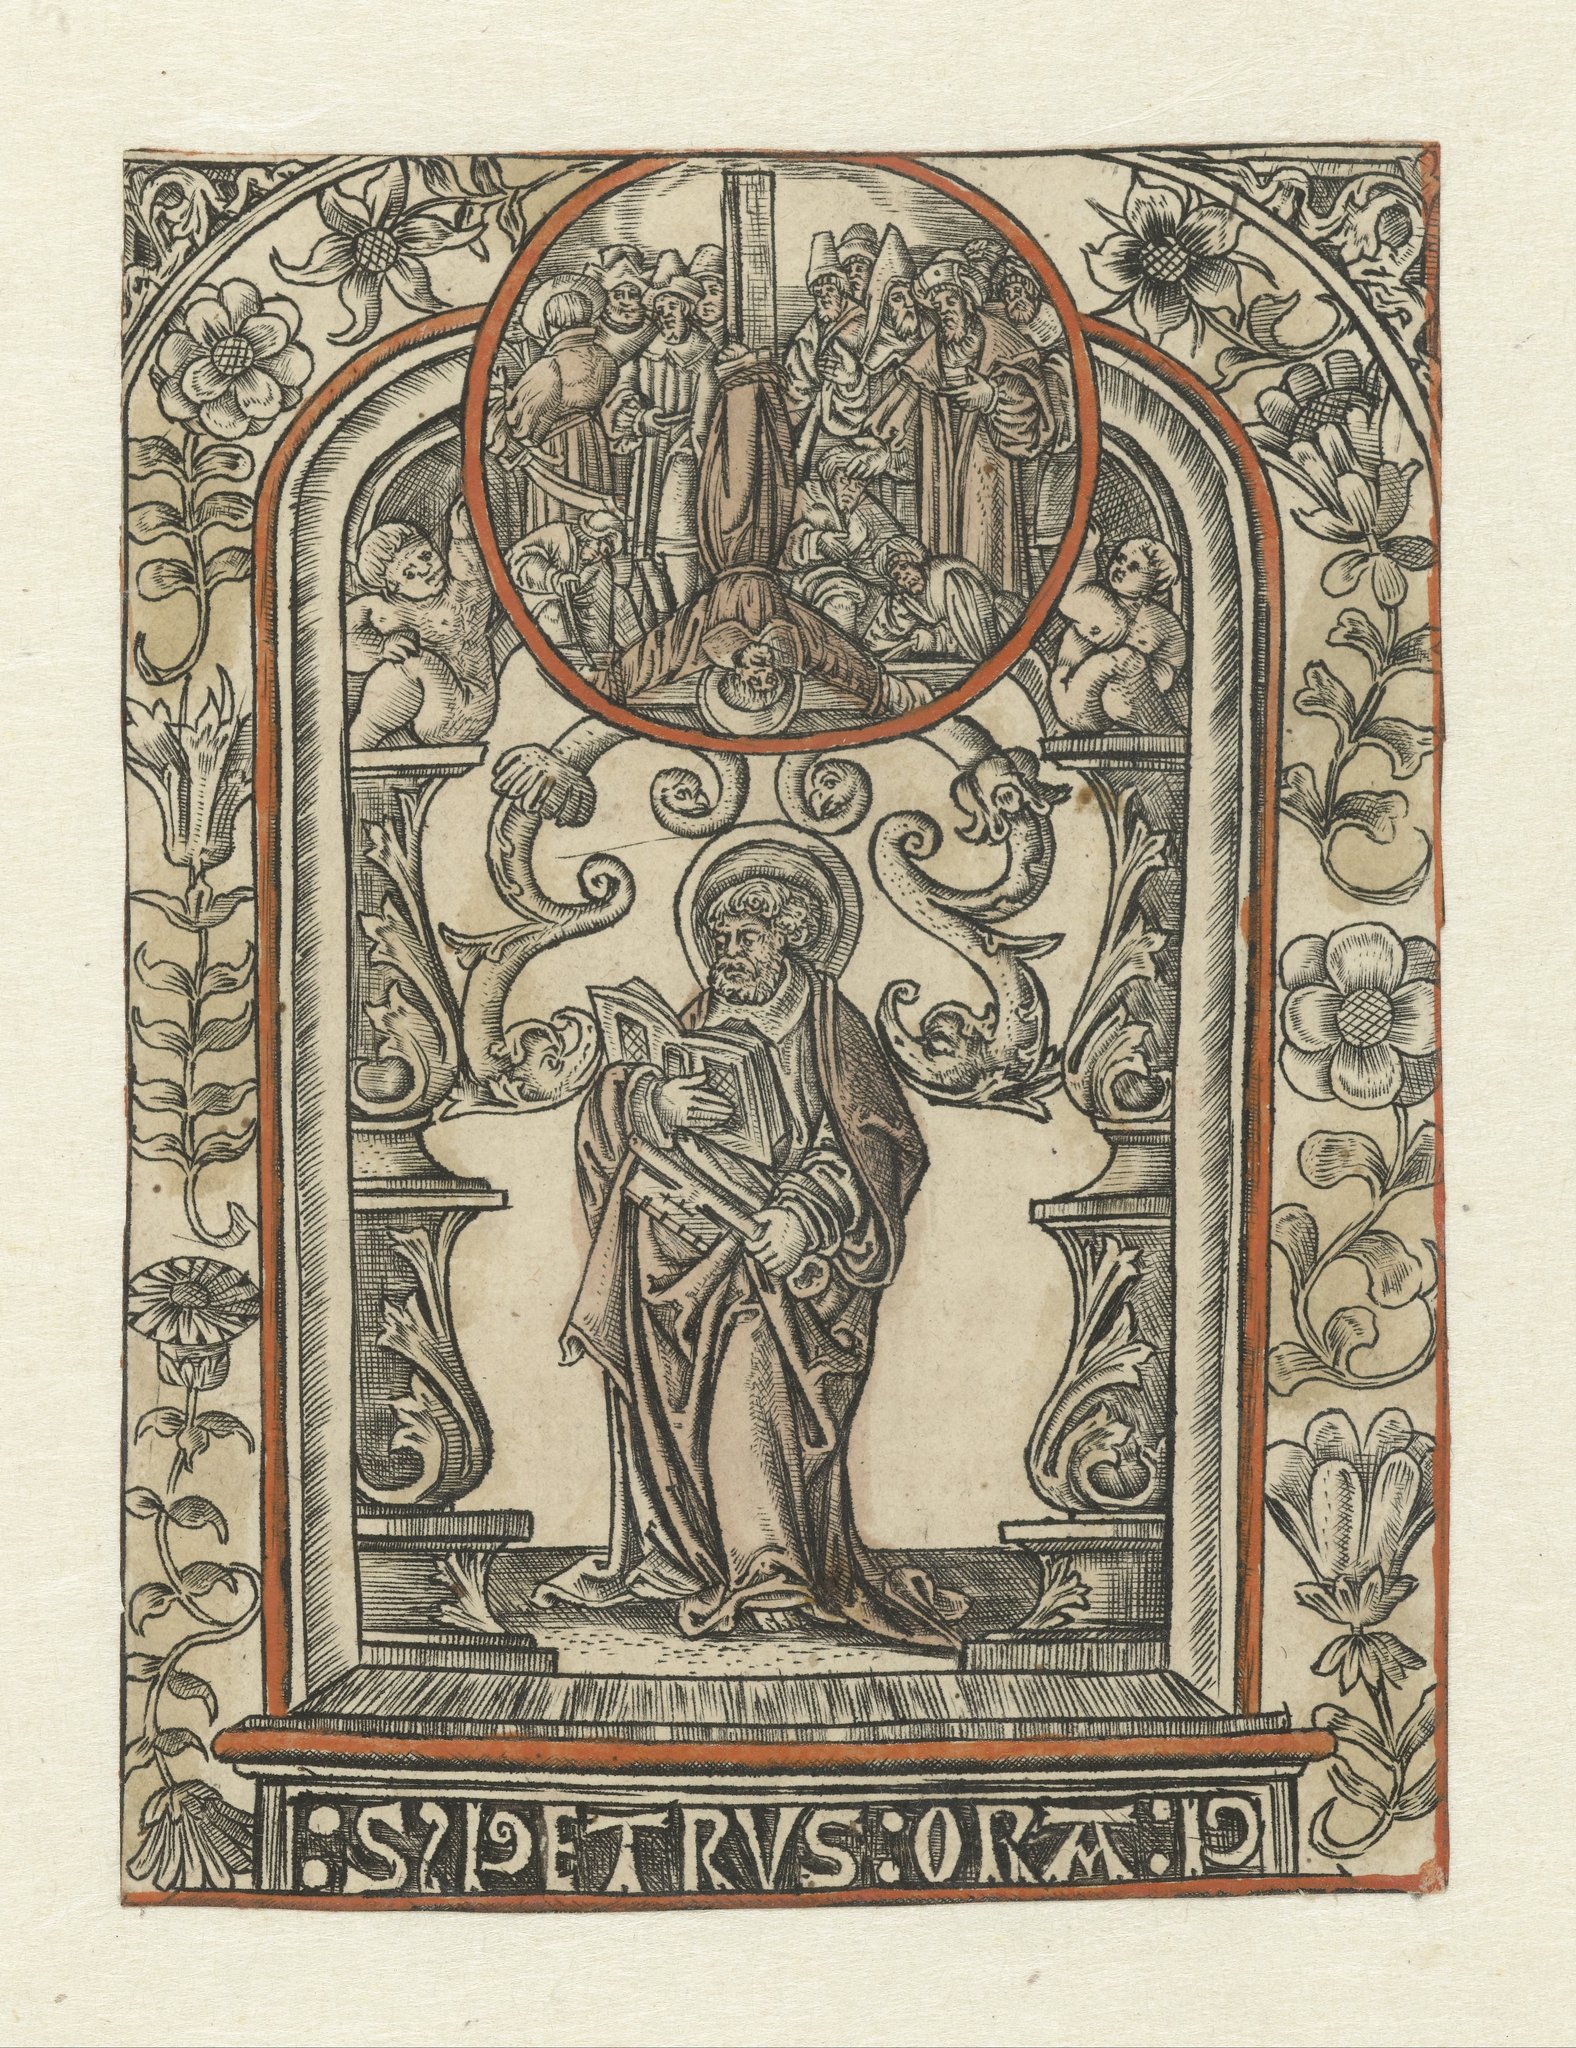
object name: print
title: De apostel Petrus en zijn martelaarschap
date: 1510-1530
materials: paper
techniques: engraving, hand coloring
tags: peter crucified upside down, the apostle peter, first bishop of rome; possible attributes: book, cock, (upturned) cross, (triple) crozier, fish, key, scroll, ship, tiara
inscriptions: collector's mark: Lugt 2760, collector's mark: Lugt 2228a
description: Prent uit serie van twaalf. Apostel Petrus met boek en sleutel in een omlijsting met bloemen. Cirkel met voorstelling van omgekeerde kruisiging van Petrus. Los blad met handgeschreven tekst in zwart en rood.